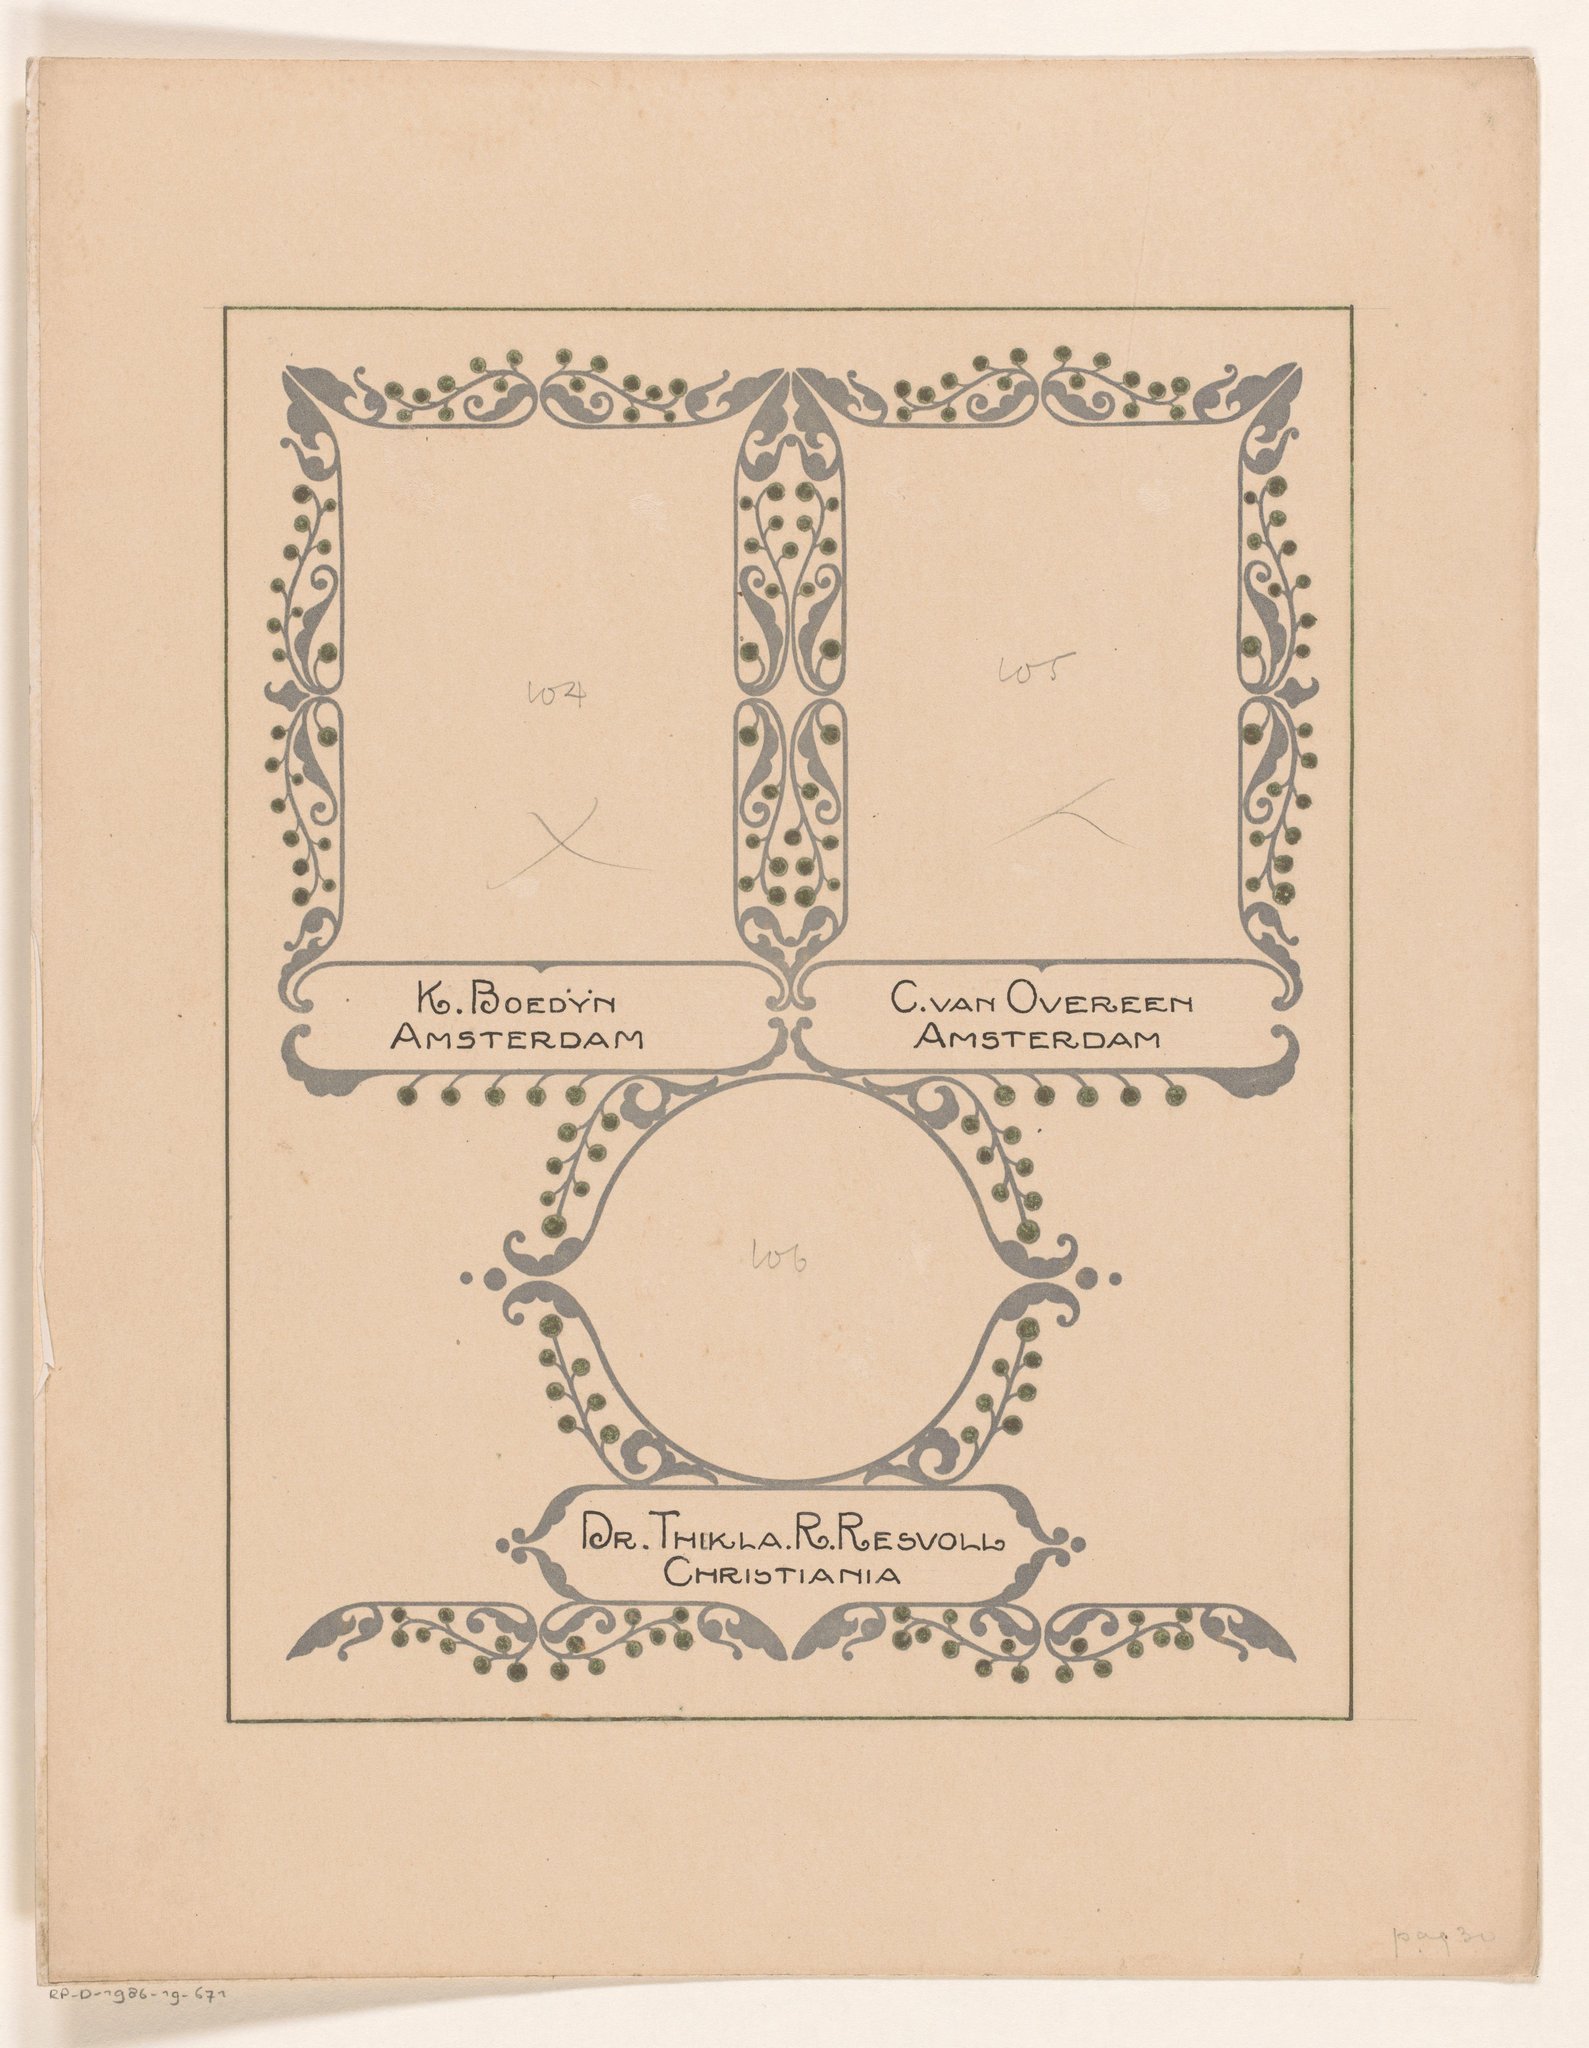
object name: drawing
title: Albumblad voor een album voor Prof. Hugo de Vries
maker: reinier willem petrus de vries (1874-1953)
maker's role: draughtsman, print maker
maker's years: 1874-1953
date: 1918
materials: paint, ink, paper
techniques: brush, lithograph, pen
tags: haarlem, hugo de vries, flowers ~ ornament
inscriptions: collector's mark: ‘R:MVS.’, annotation: ‘pag 30’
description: Rechthoekig kader met bloem- en bladornamenten met daarin twee vierkante vakken en één rond vak voor portretten met onder elk vak de naam van de geportretteerde.